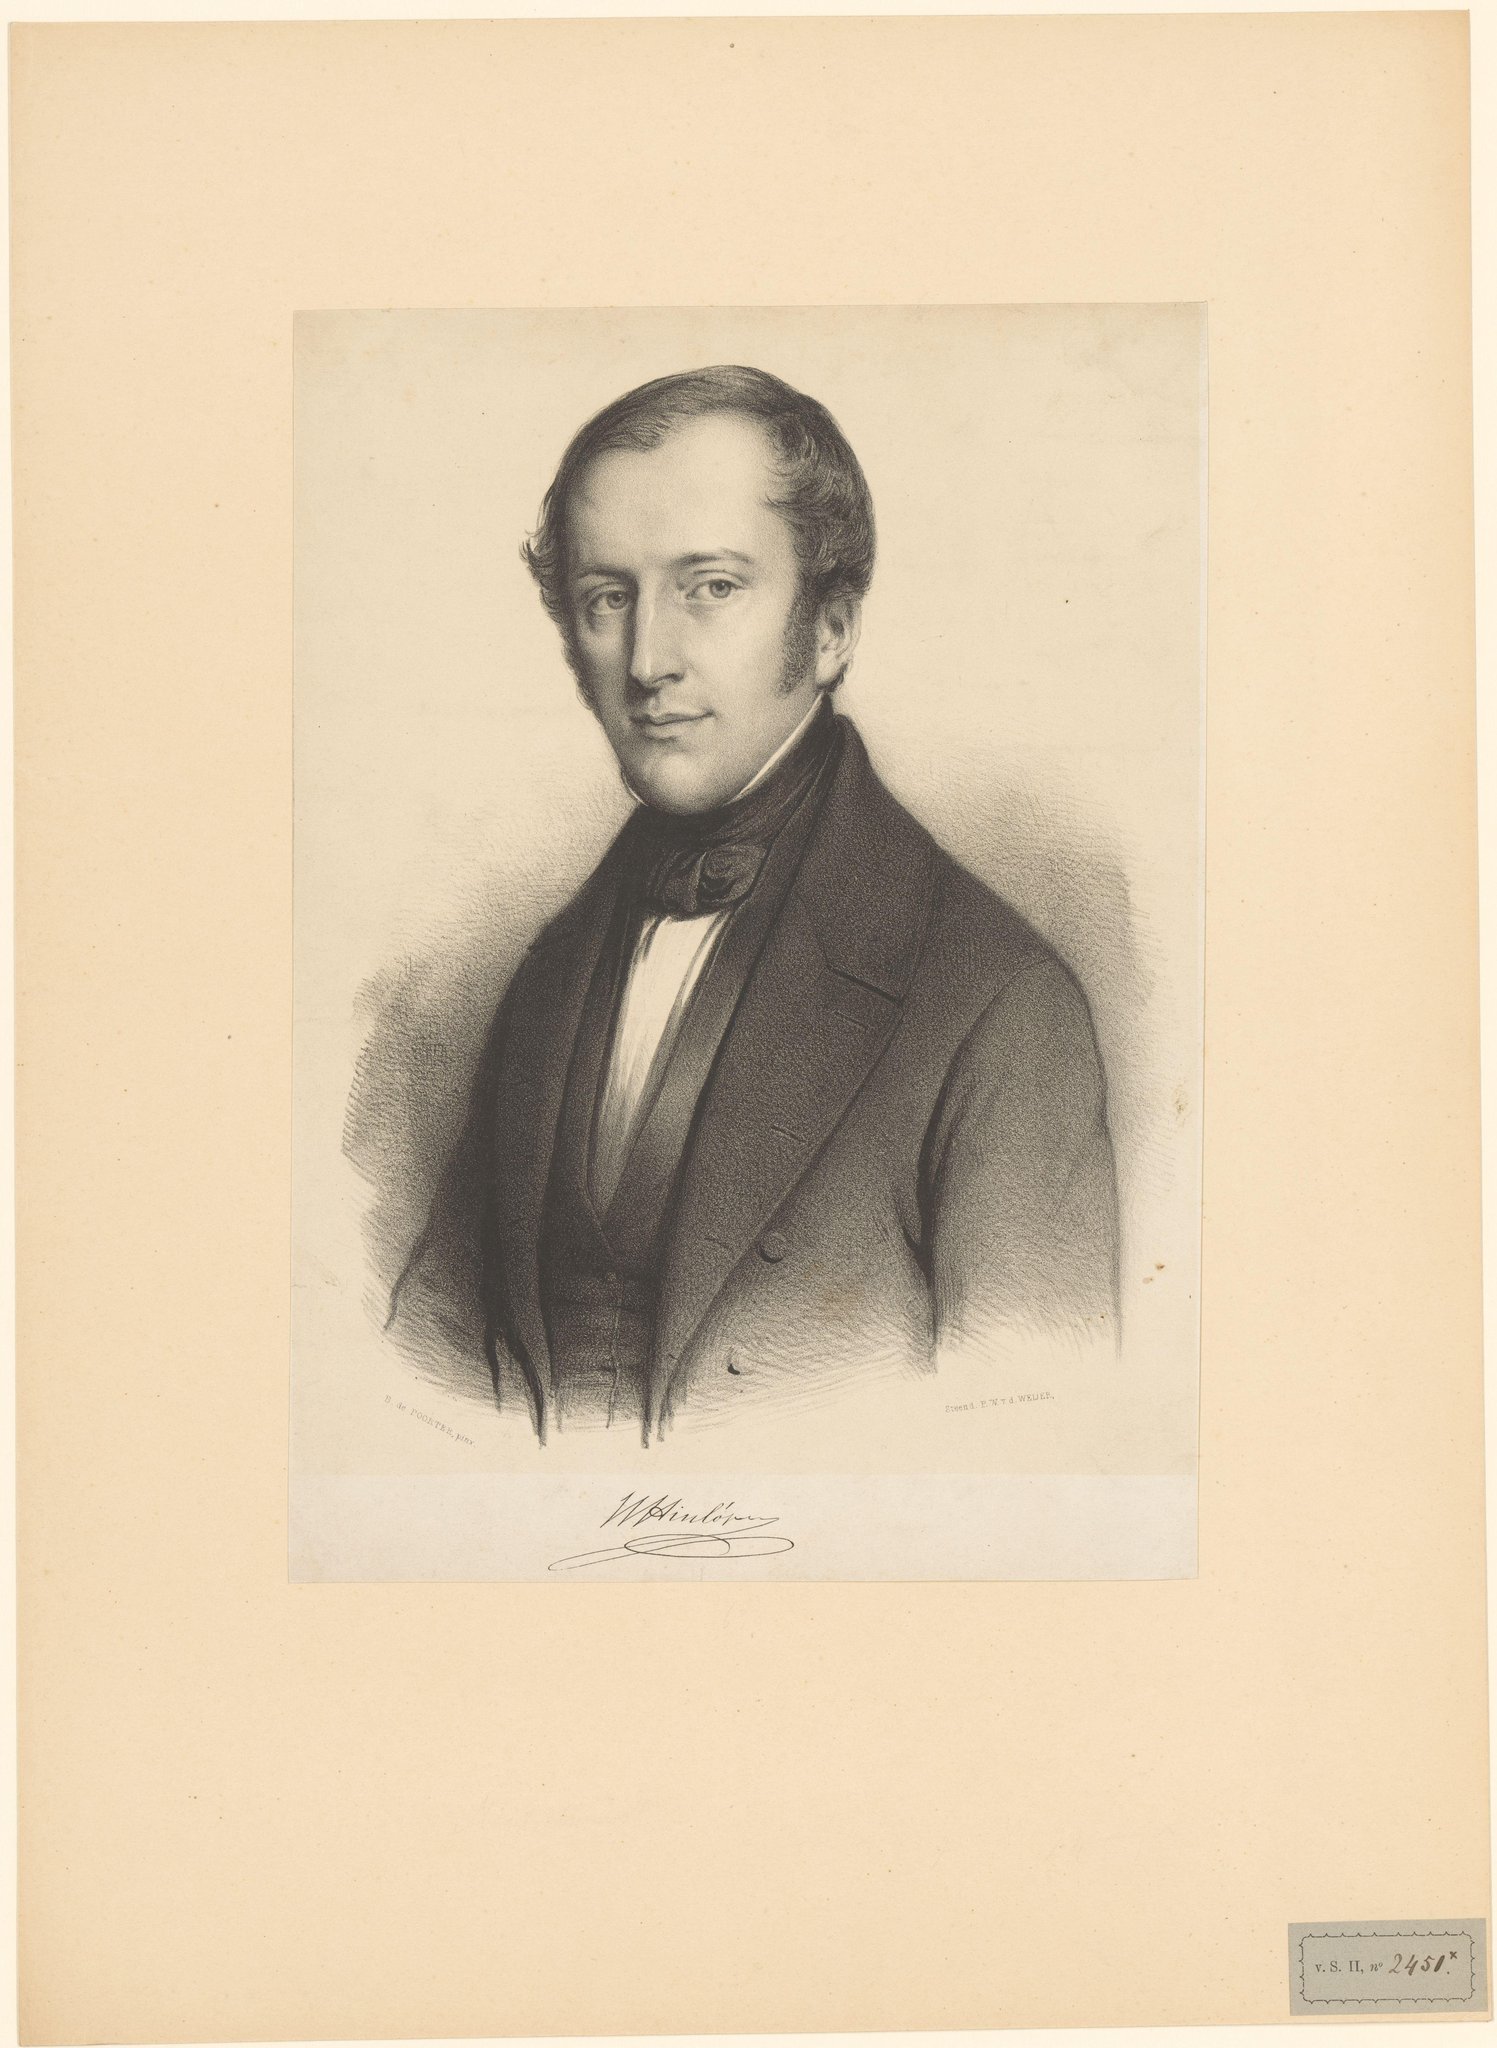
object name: print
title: Portret van Jan Jacob Hinlopen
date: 1842-1880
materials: paper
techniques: tone lithography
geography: utrecht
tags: utrecht, historical persons (+ (full) bust portrait)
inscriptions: collector's mark: Lugt 2228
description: Onder het portret de signatuur van de geportretteerde.